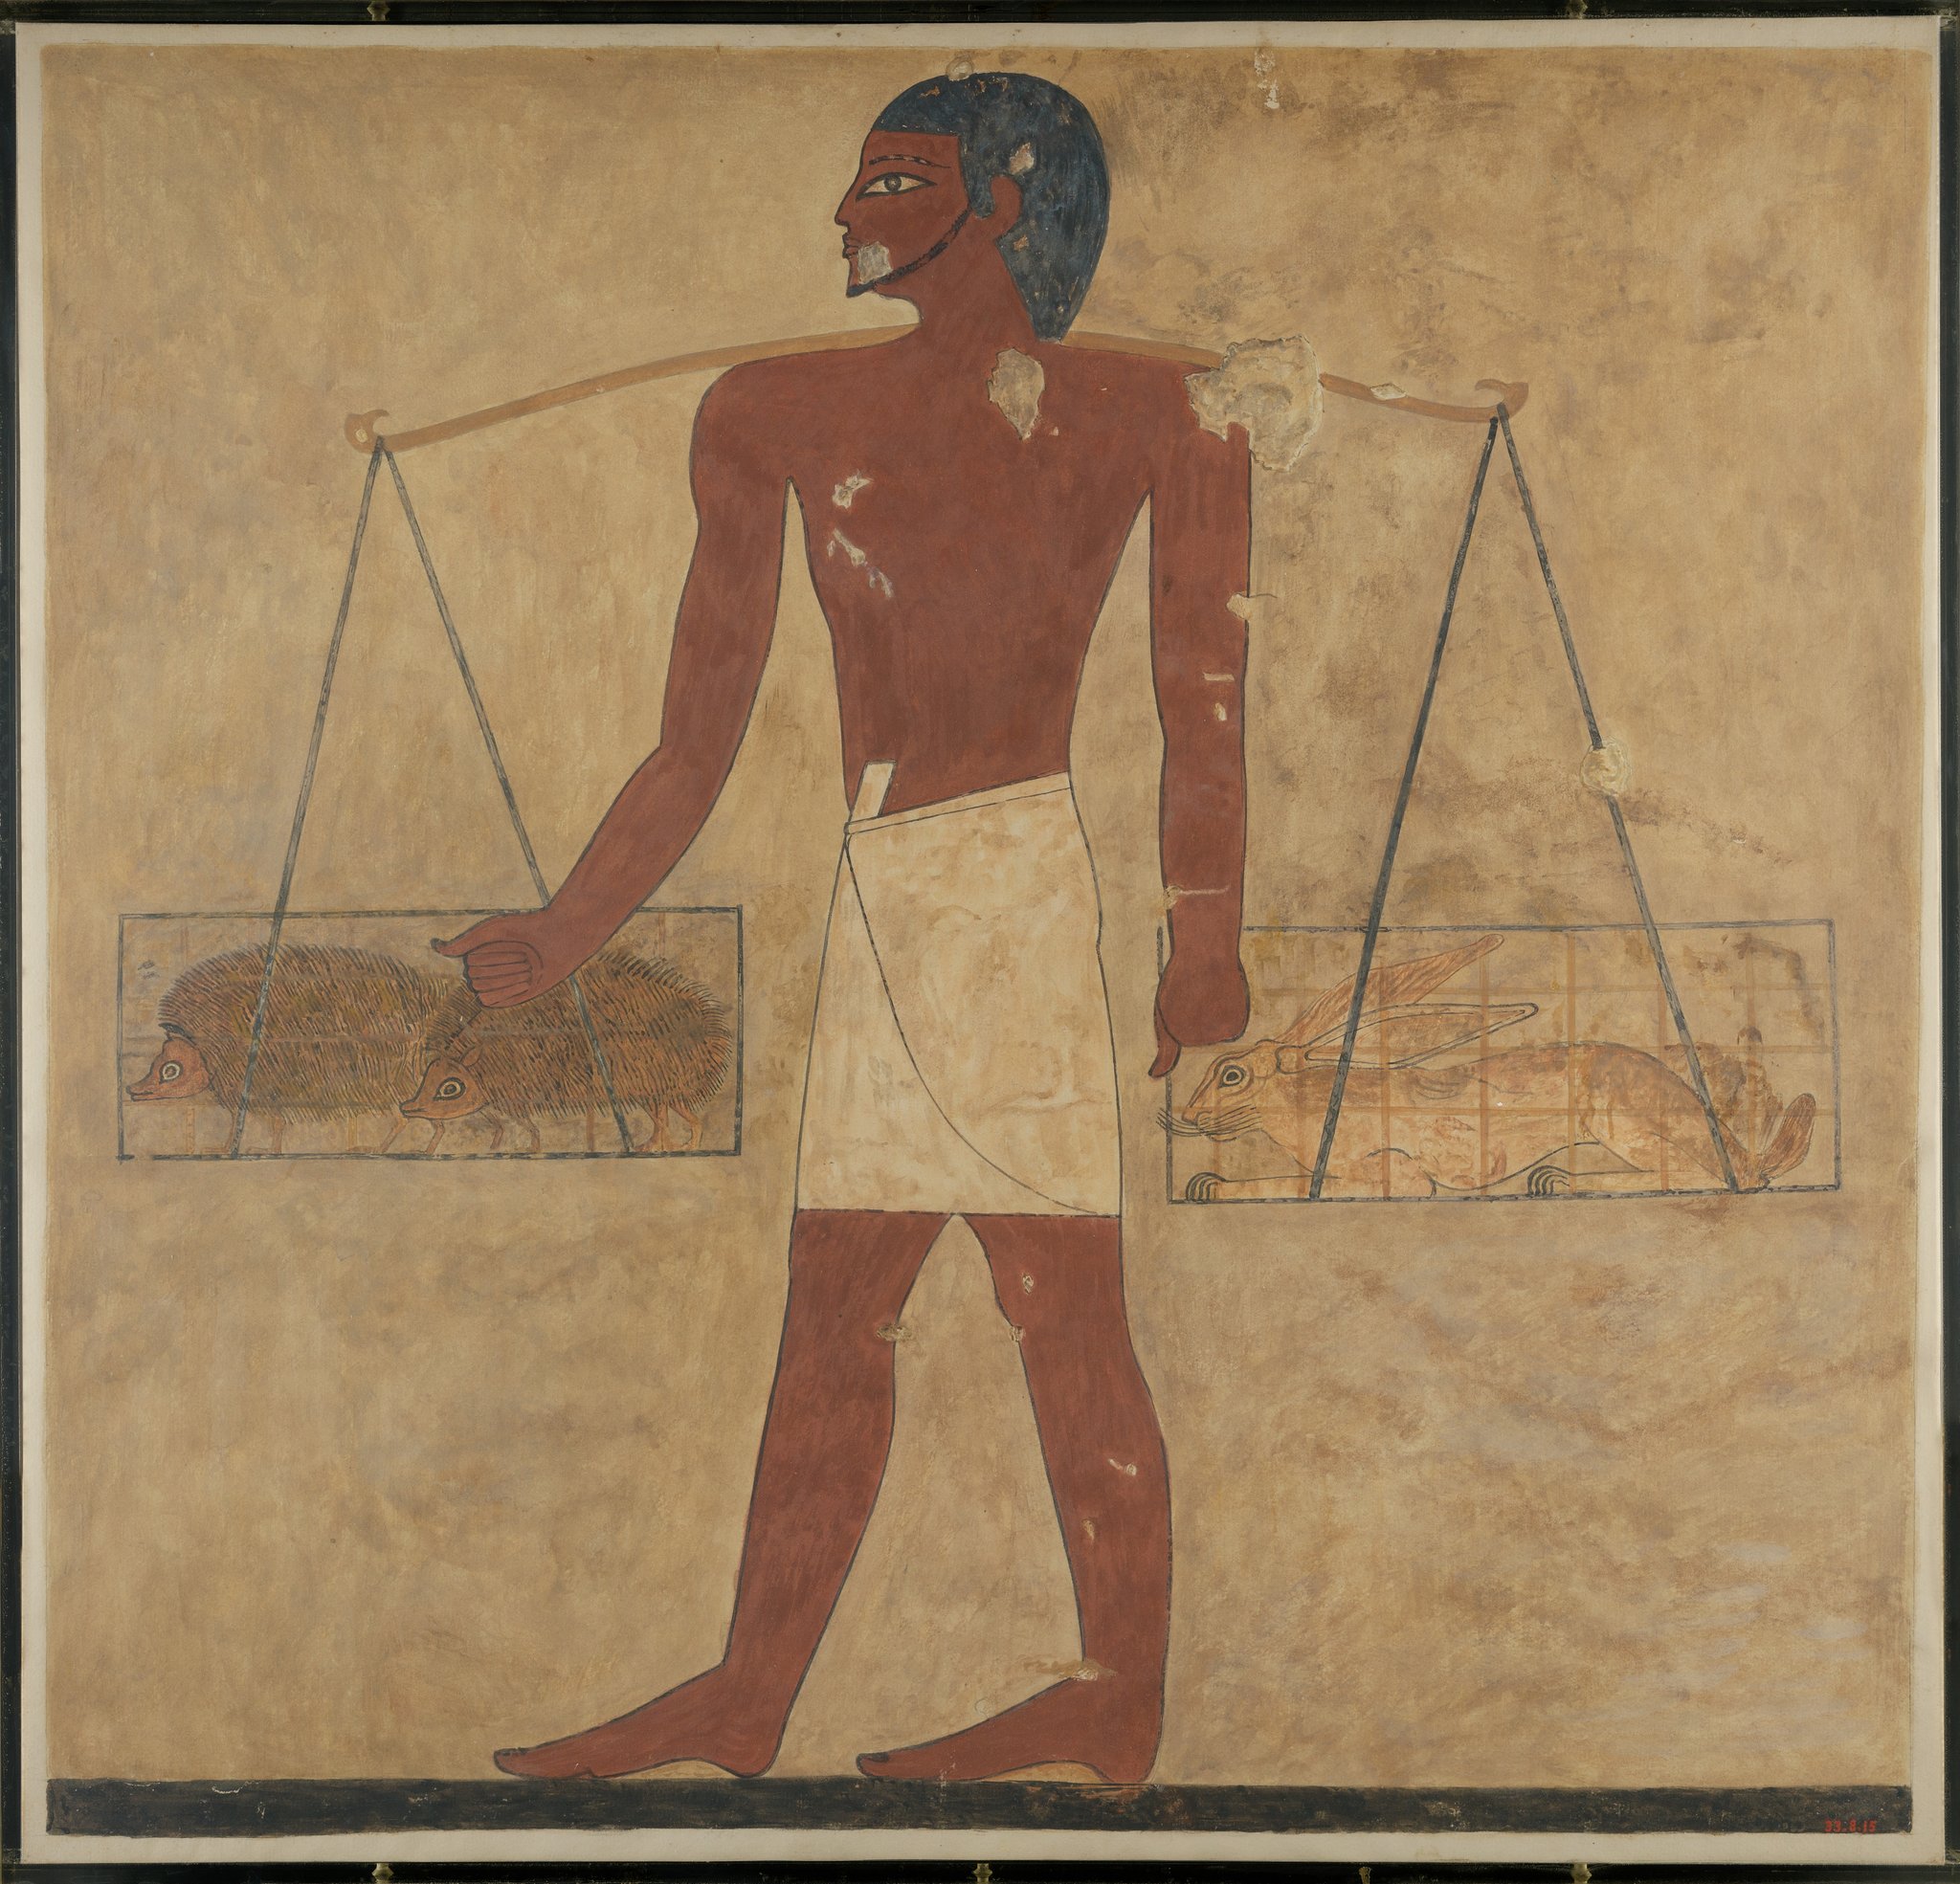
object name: facsimile, khnumhotep beni hasan 3, hedgehog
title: Man Transporting a Hedgehog and a Hare, Tomb of Khnumhotep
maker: norman de garis davies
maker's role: artist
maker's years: 1865-1941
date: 1897-1878 BCE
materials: paper, paint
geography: egypt